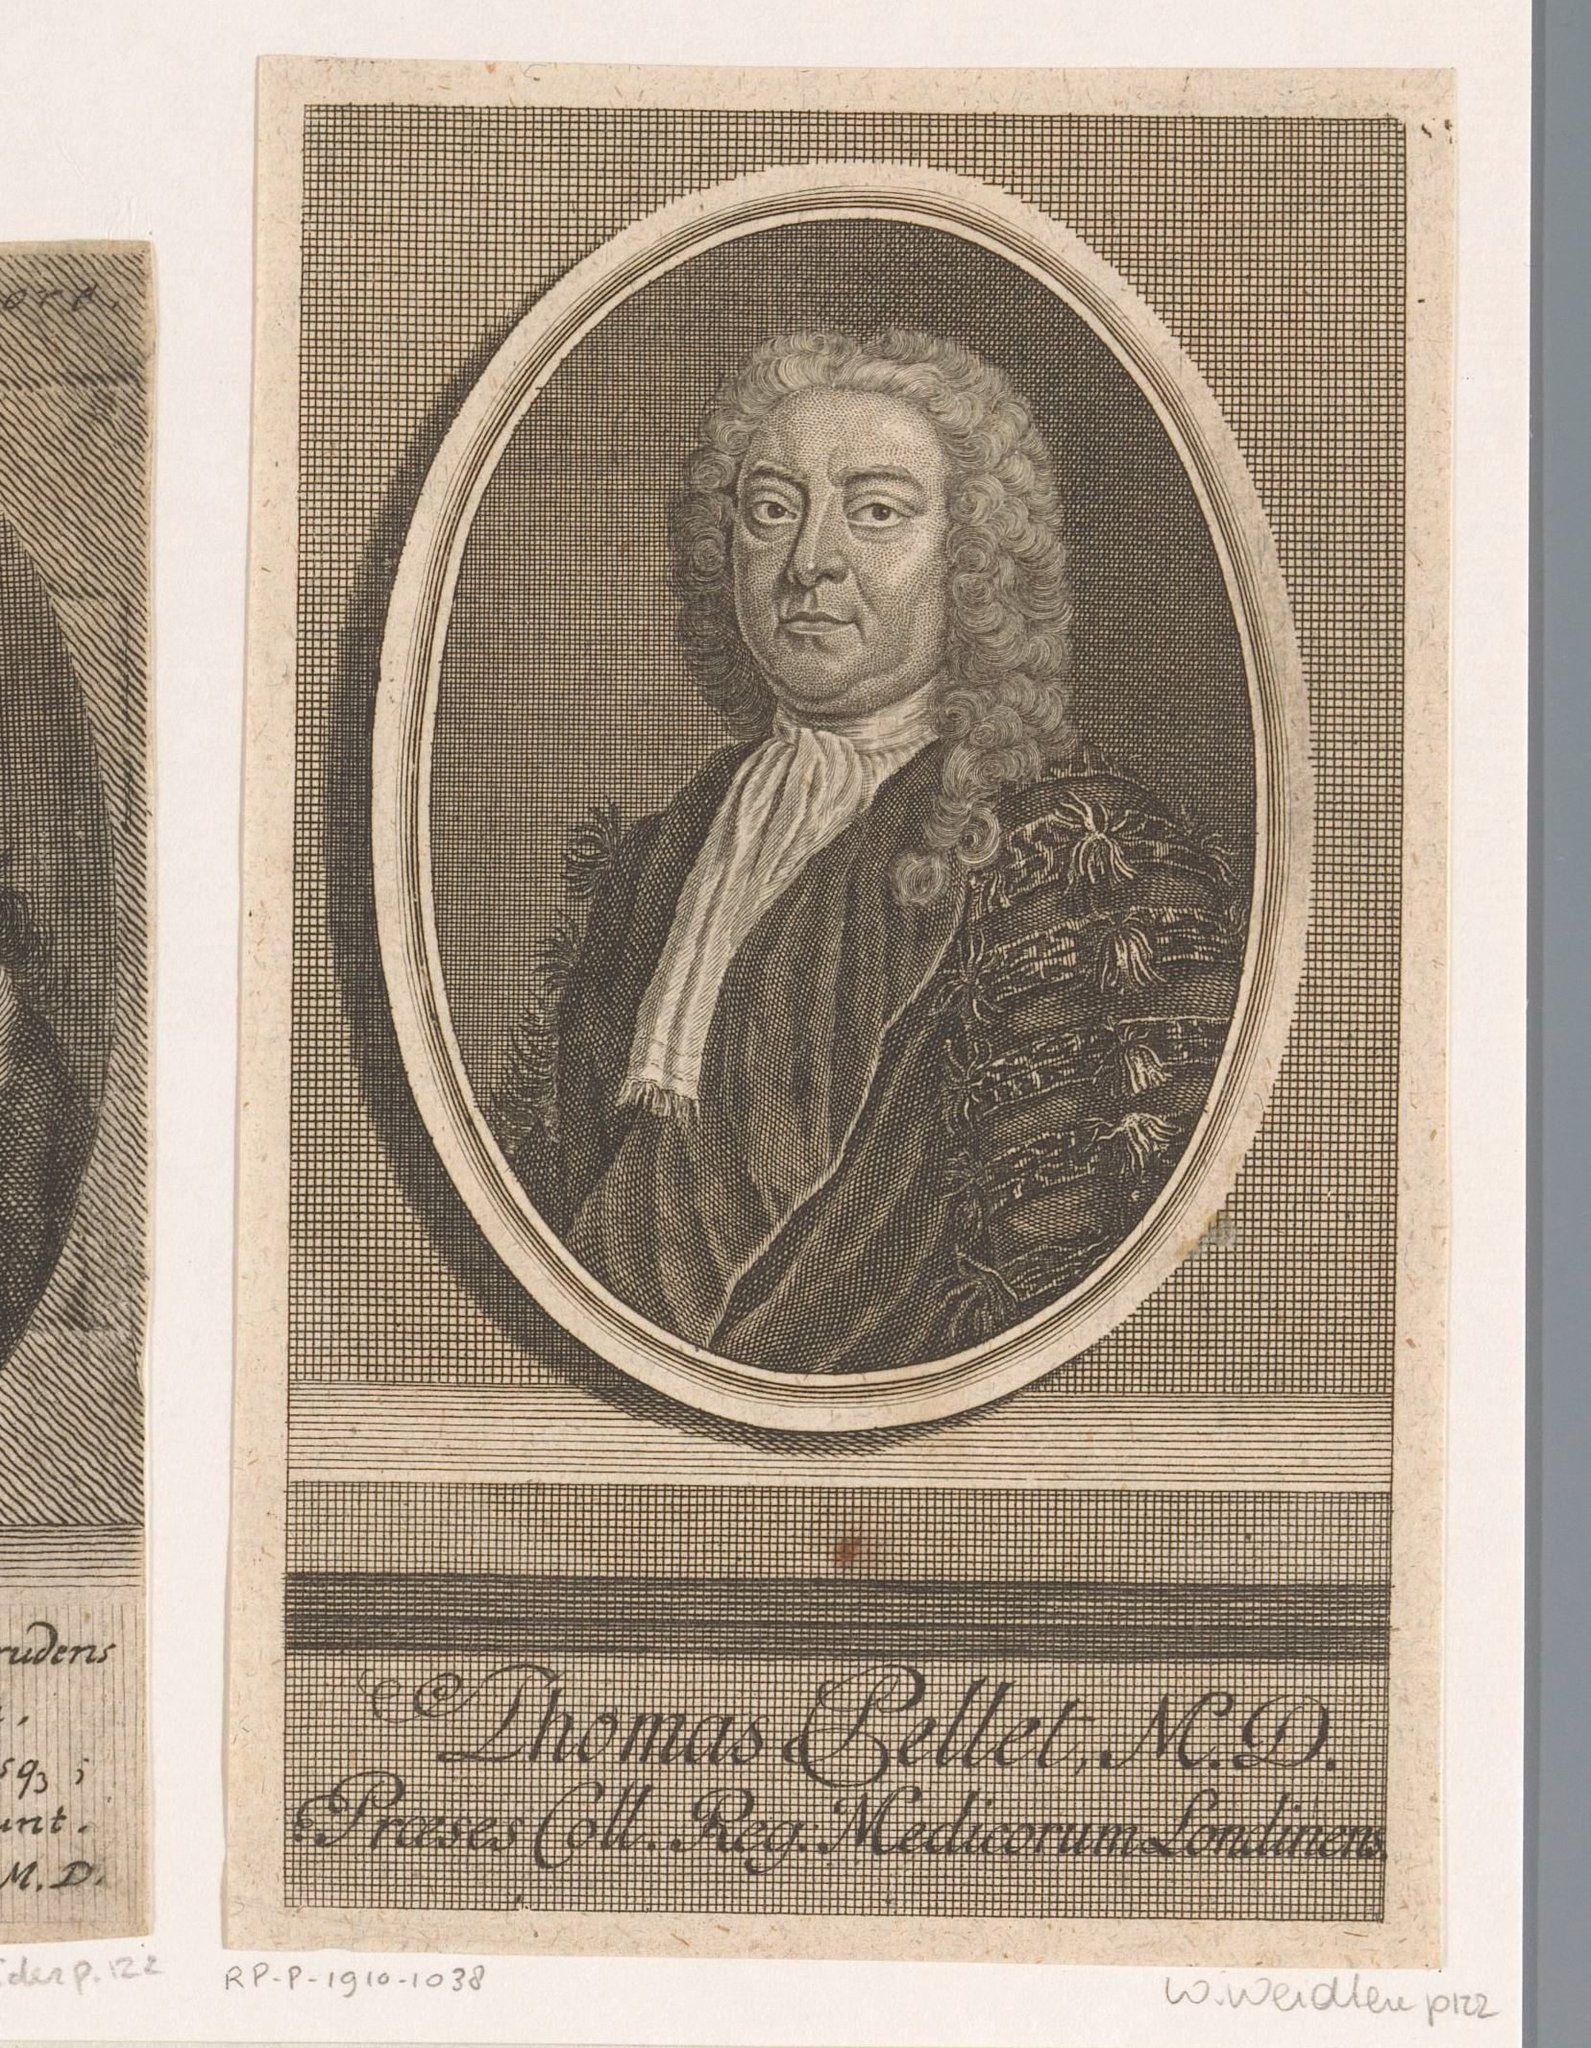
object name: print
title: Portret van Thomas Pellet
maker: johann martin bernigeroth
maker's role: print maker, publisher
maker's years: 1713-1767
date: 1735-1744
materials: paper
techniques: engraving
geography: leipzig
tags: historical persons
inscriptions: collector's mark: Lugt 2228